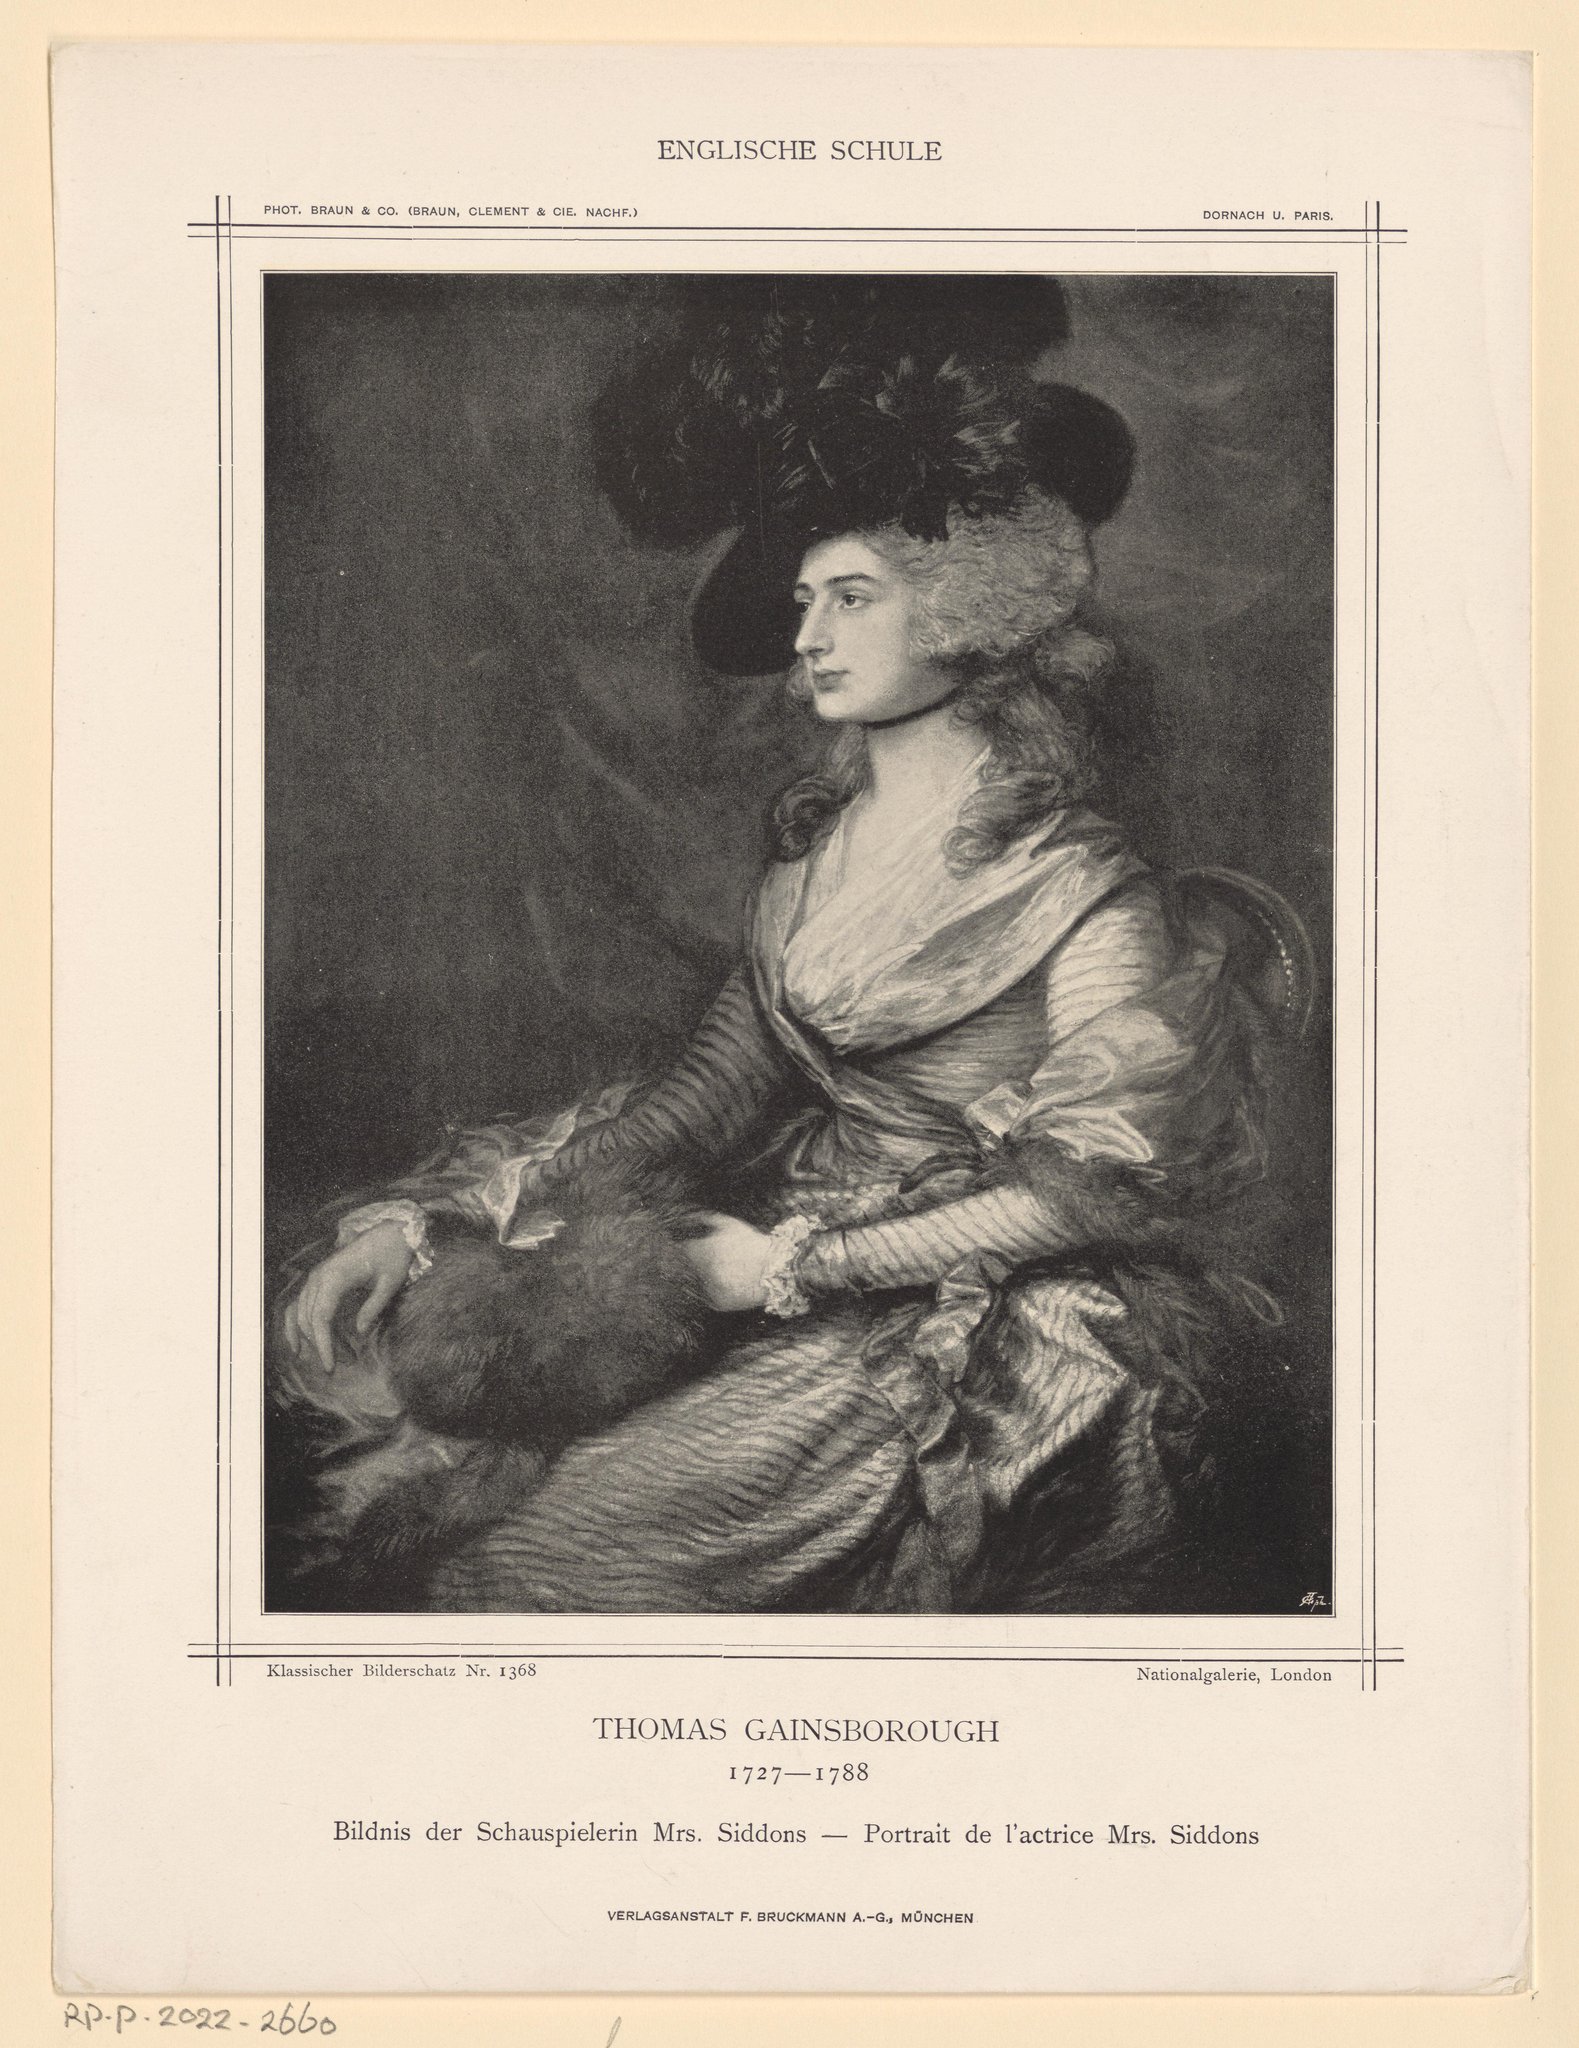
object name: photomechanical print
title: Portret van Sarah Siddons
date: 1863-1898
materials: paper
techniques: autotype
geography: paris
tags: london, historical persons, portrait of actor, actress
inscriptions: collector's mark: Lugt 2228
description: Fotomechanische afdruk mogelijk uit een deel van: Reber, Franz von en Adolph Bayersdorfer. Klassischer Bilderschatz. München: Verlagsanstalt für Kunst und Wissenschaft.